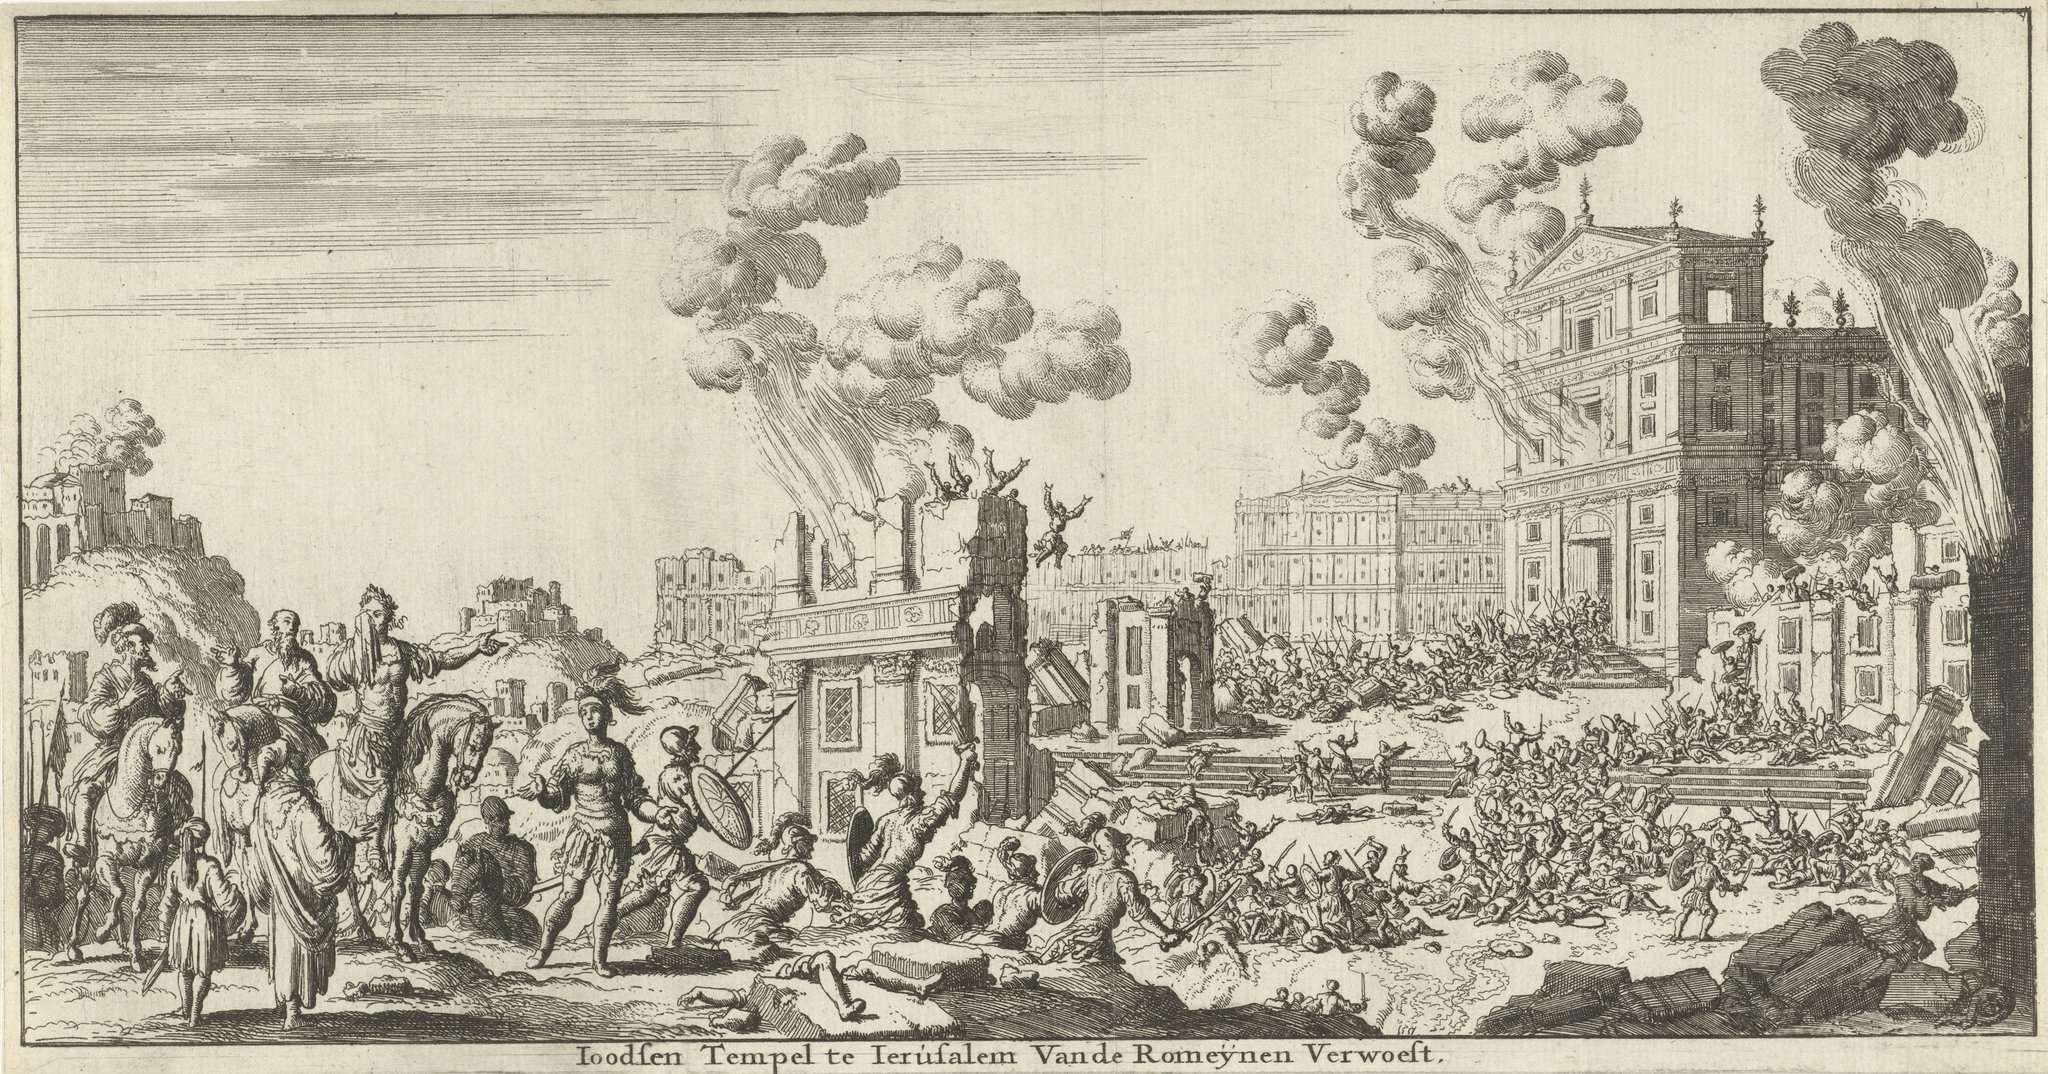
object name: print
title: Romeinen verwoesten een Joodse tempel te Jeruzalem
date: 1682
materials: paper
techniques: etching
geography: amsterdam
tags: ruin of a building ~ architecture, attack ~ siege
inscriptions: collector's mark: Lugt 2228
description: Illustratie opgenomen in: Cunaeus, Petrus. De republyk der Hebreen, of gemeenebest der joden, 3 delen. Amsterdam: Wilhelmus Goeree, 1682, dl. 1, p. 256.